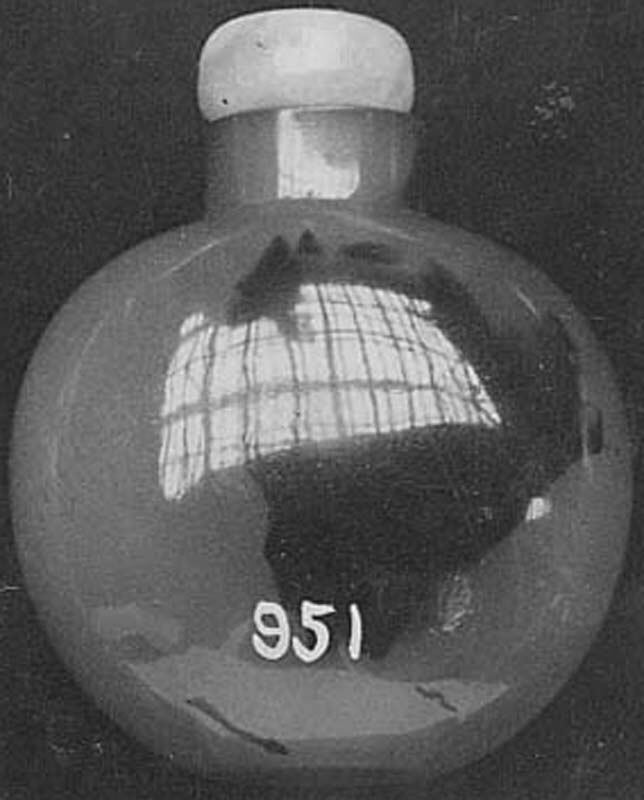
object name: snuff bottle with stopper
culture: chinese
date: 1701-1900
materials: stone